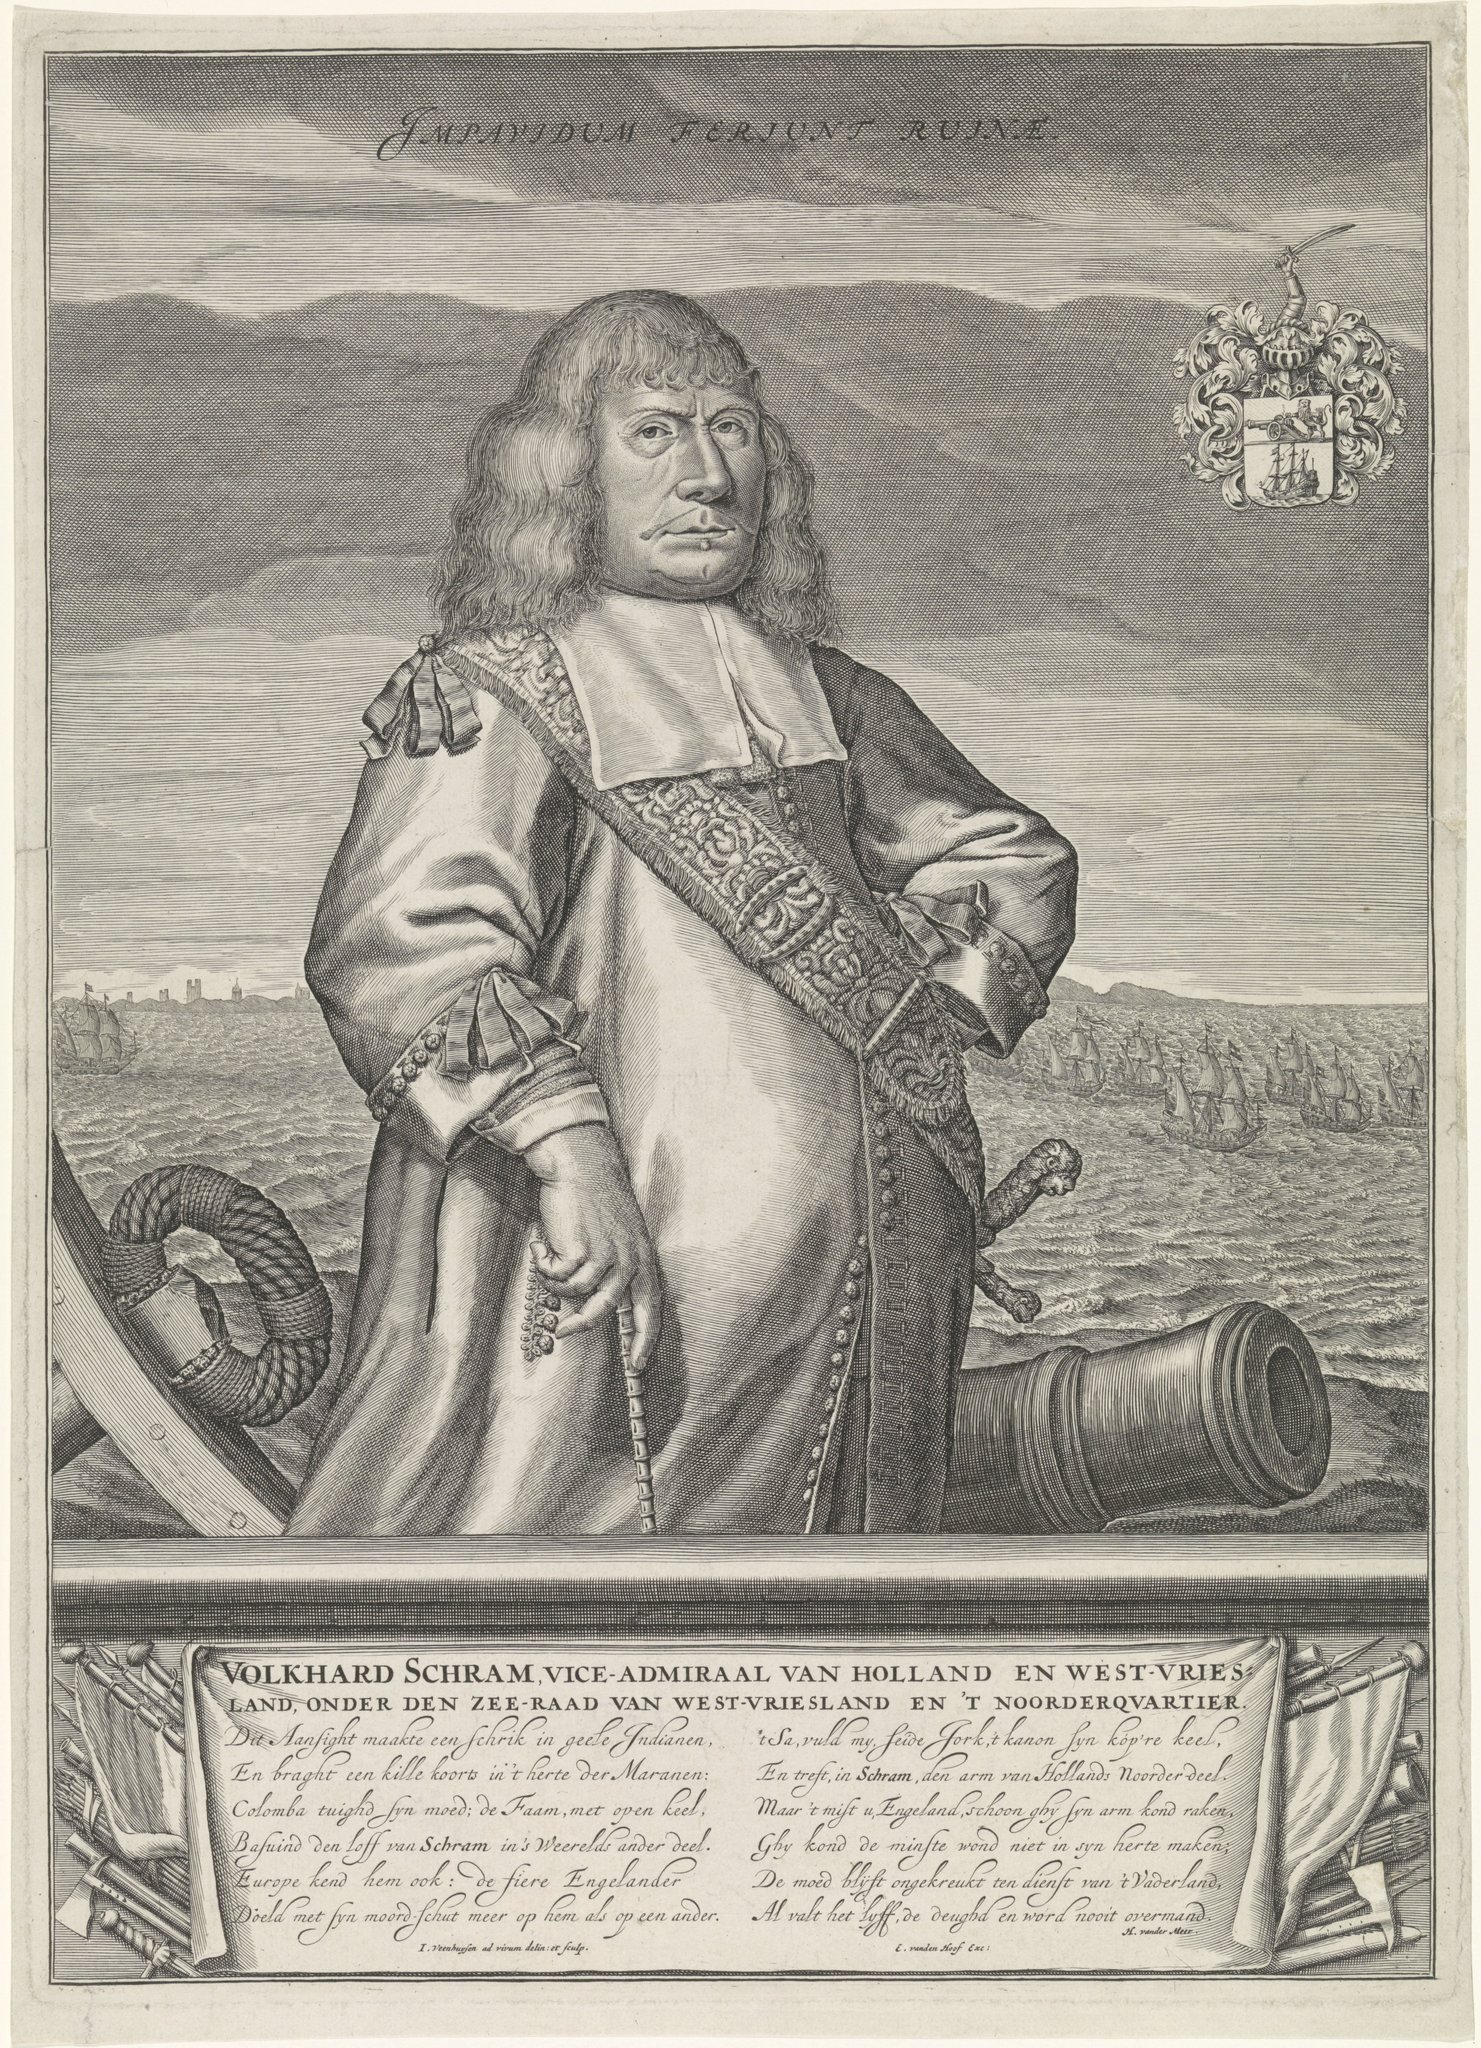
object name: print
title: Portret van Volkert Schram, Vice-admiraal van Holland en West-Friesland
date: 1656-1686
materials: paper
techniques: engraving, etching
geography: enkhuizen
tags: ships (in general), firearms: cannon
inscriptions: collector's mark: Lugt 2228